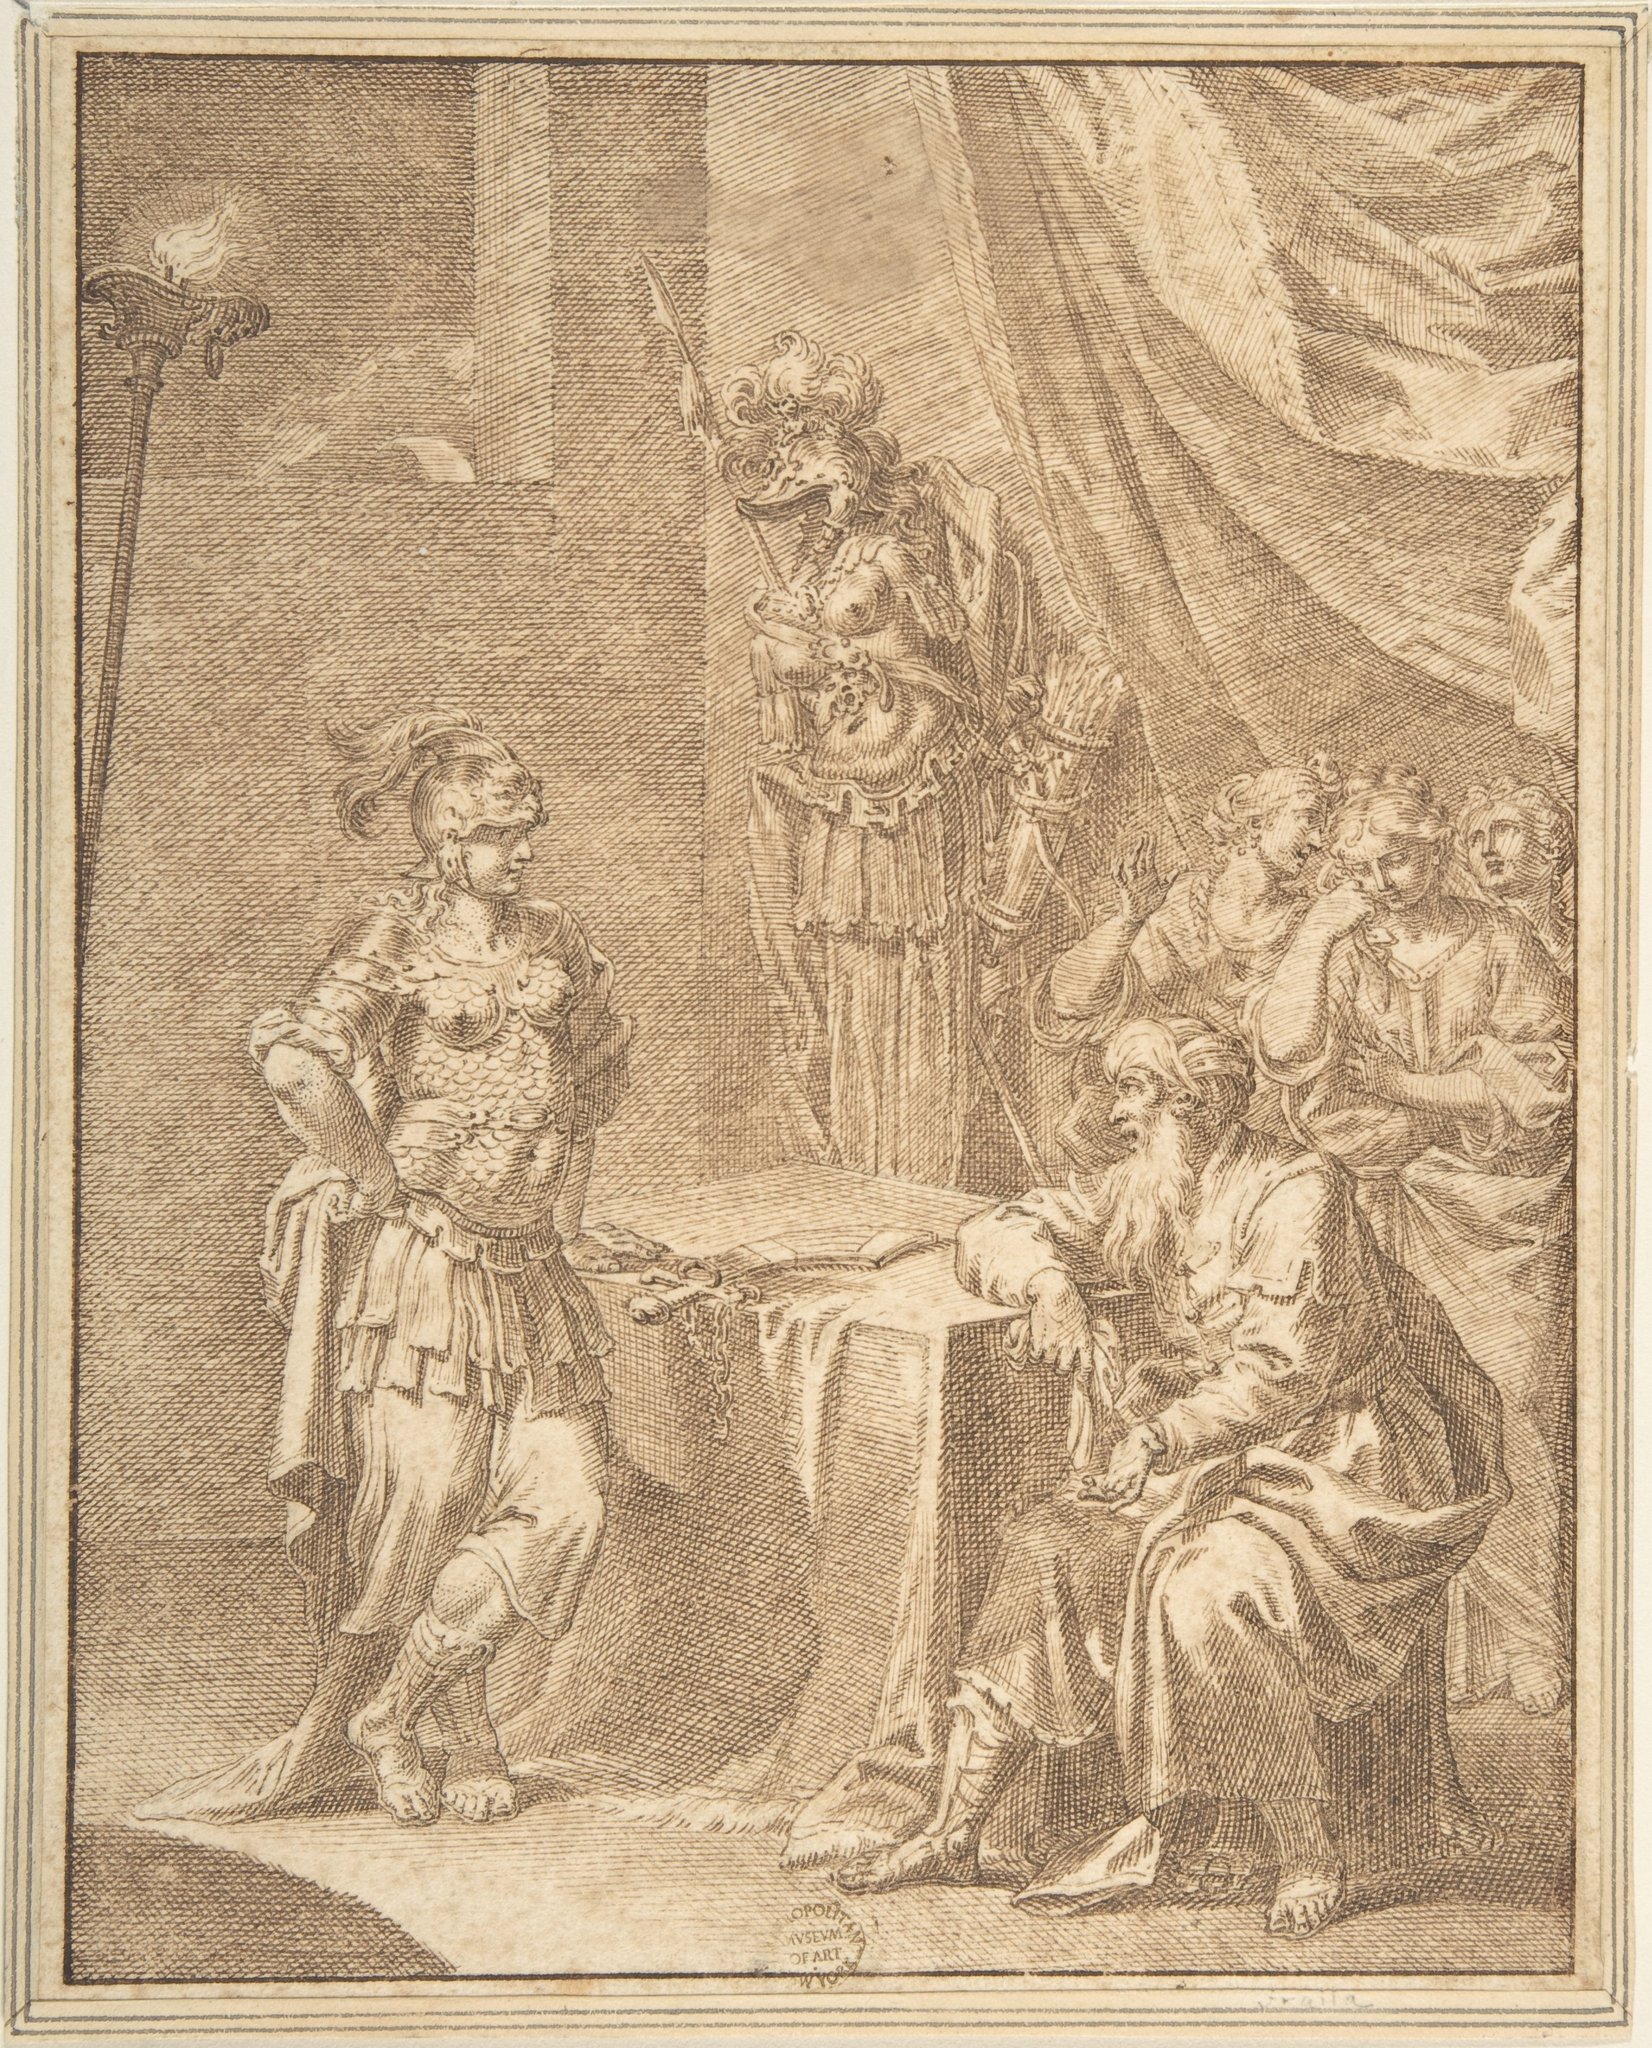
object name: drawing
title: Historical Scene: Study for an Engraving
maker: anonymous, italian, 18th century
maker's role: artist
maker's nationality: italian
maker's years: 1700-1800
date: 1701-1800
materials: ink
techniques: pen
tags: armor,weapons,men,women